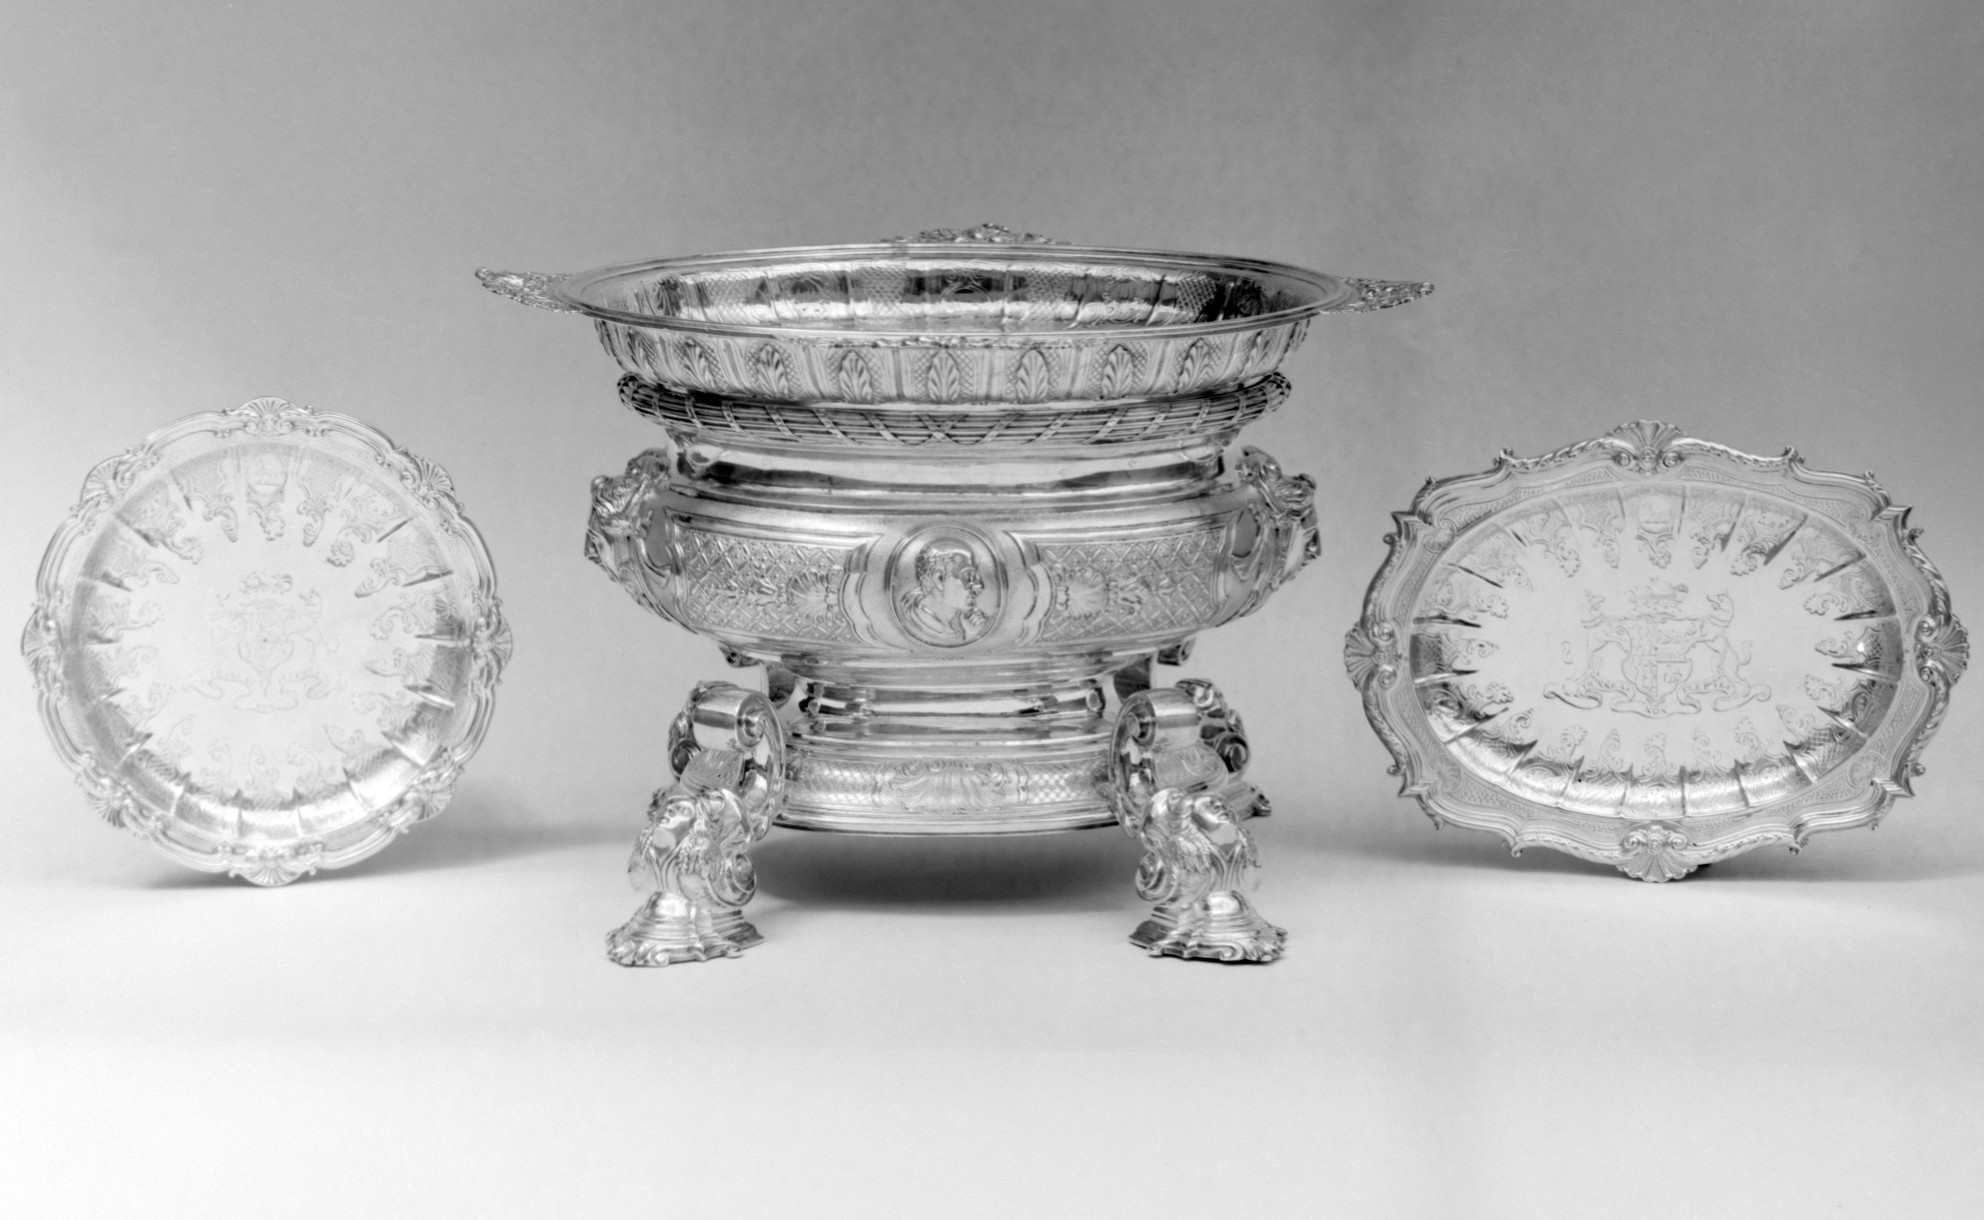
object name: centerpiece with cover and dish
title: Centerpiece with cover and eight accessory dishes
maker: paul de lamerie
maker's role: maker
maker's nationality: british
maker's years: 1688-1751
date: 1733-1734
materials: silver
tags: men,profiles,coat of arms